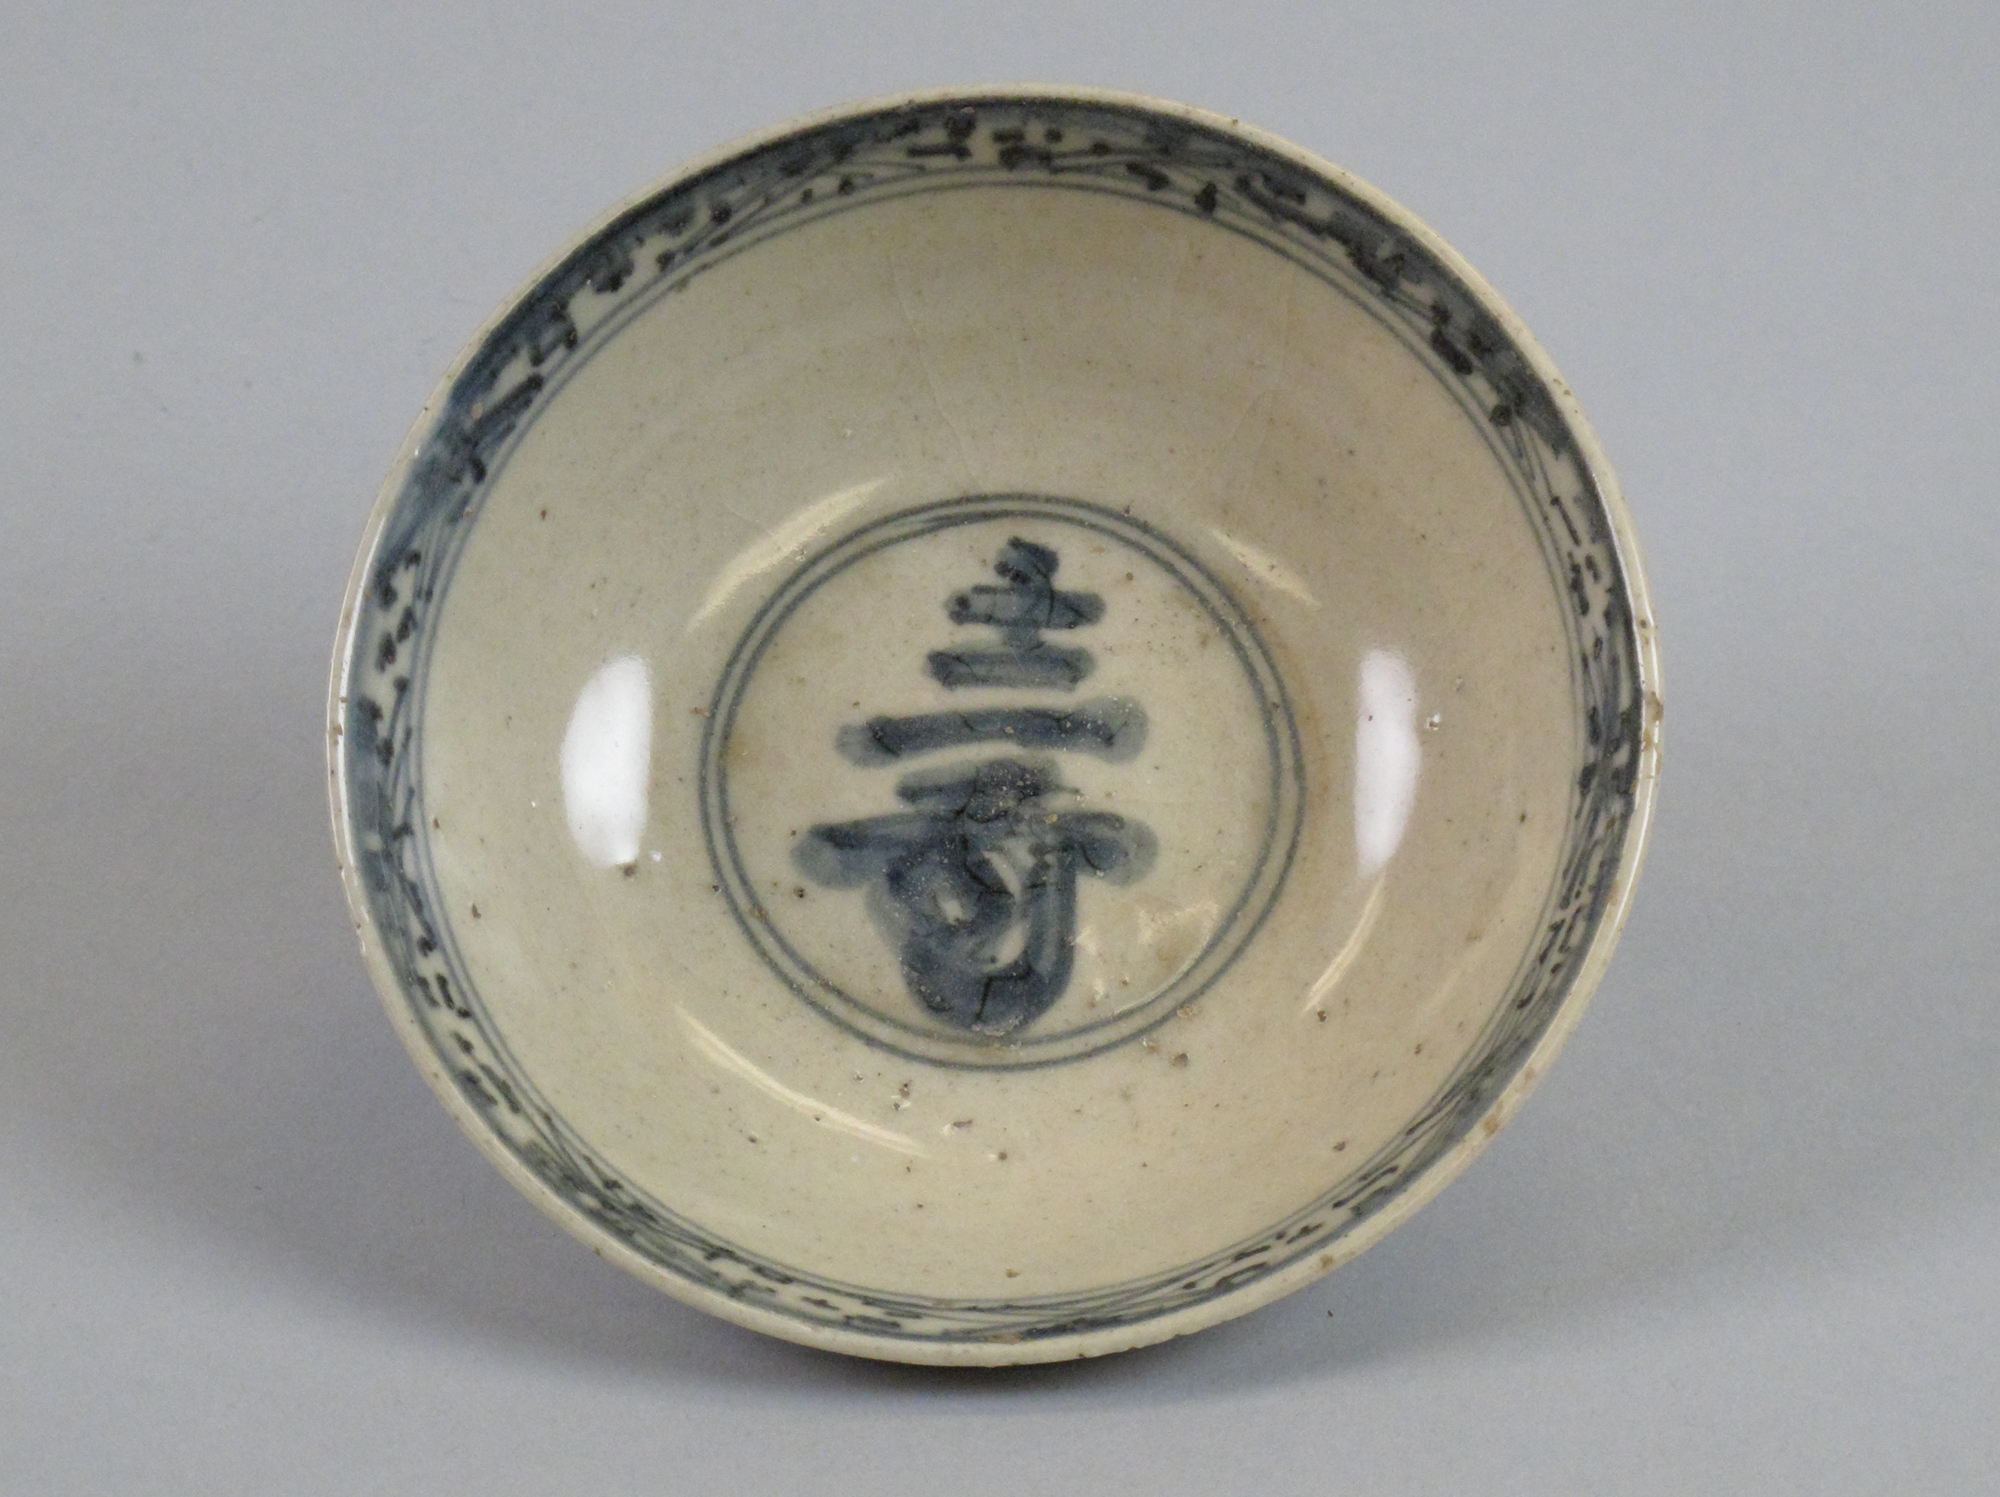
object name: bowl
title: Bowl with character of longevity (shou)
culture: chinese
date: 1567-1633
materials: cobalt, porcelain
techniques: painting, underglaze